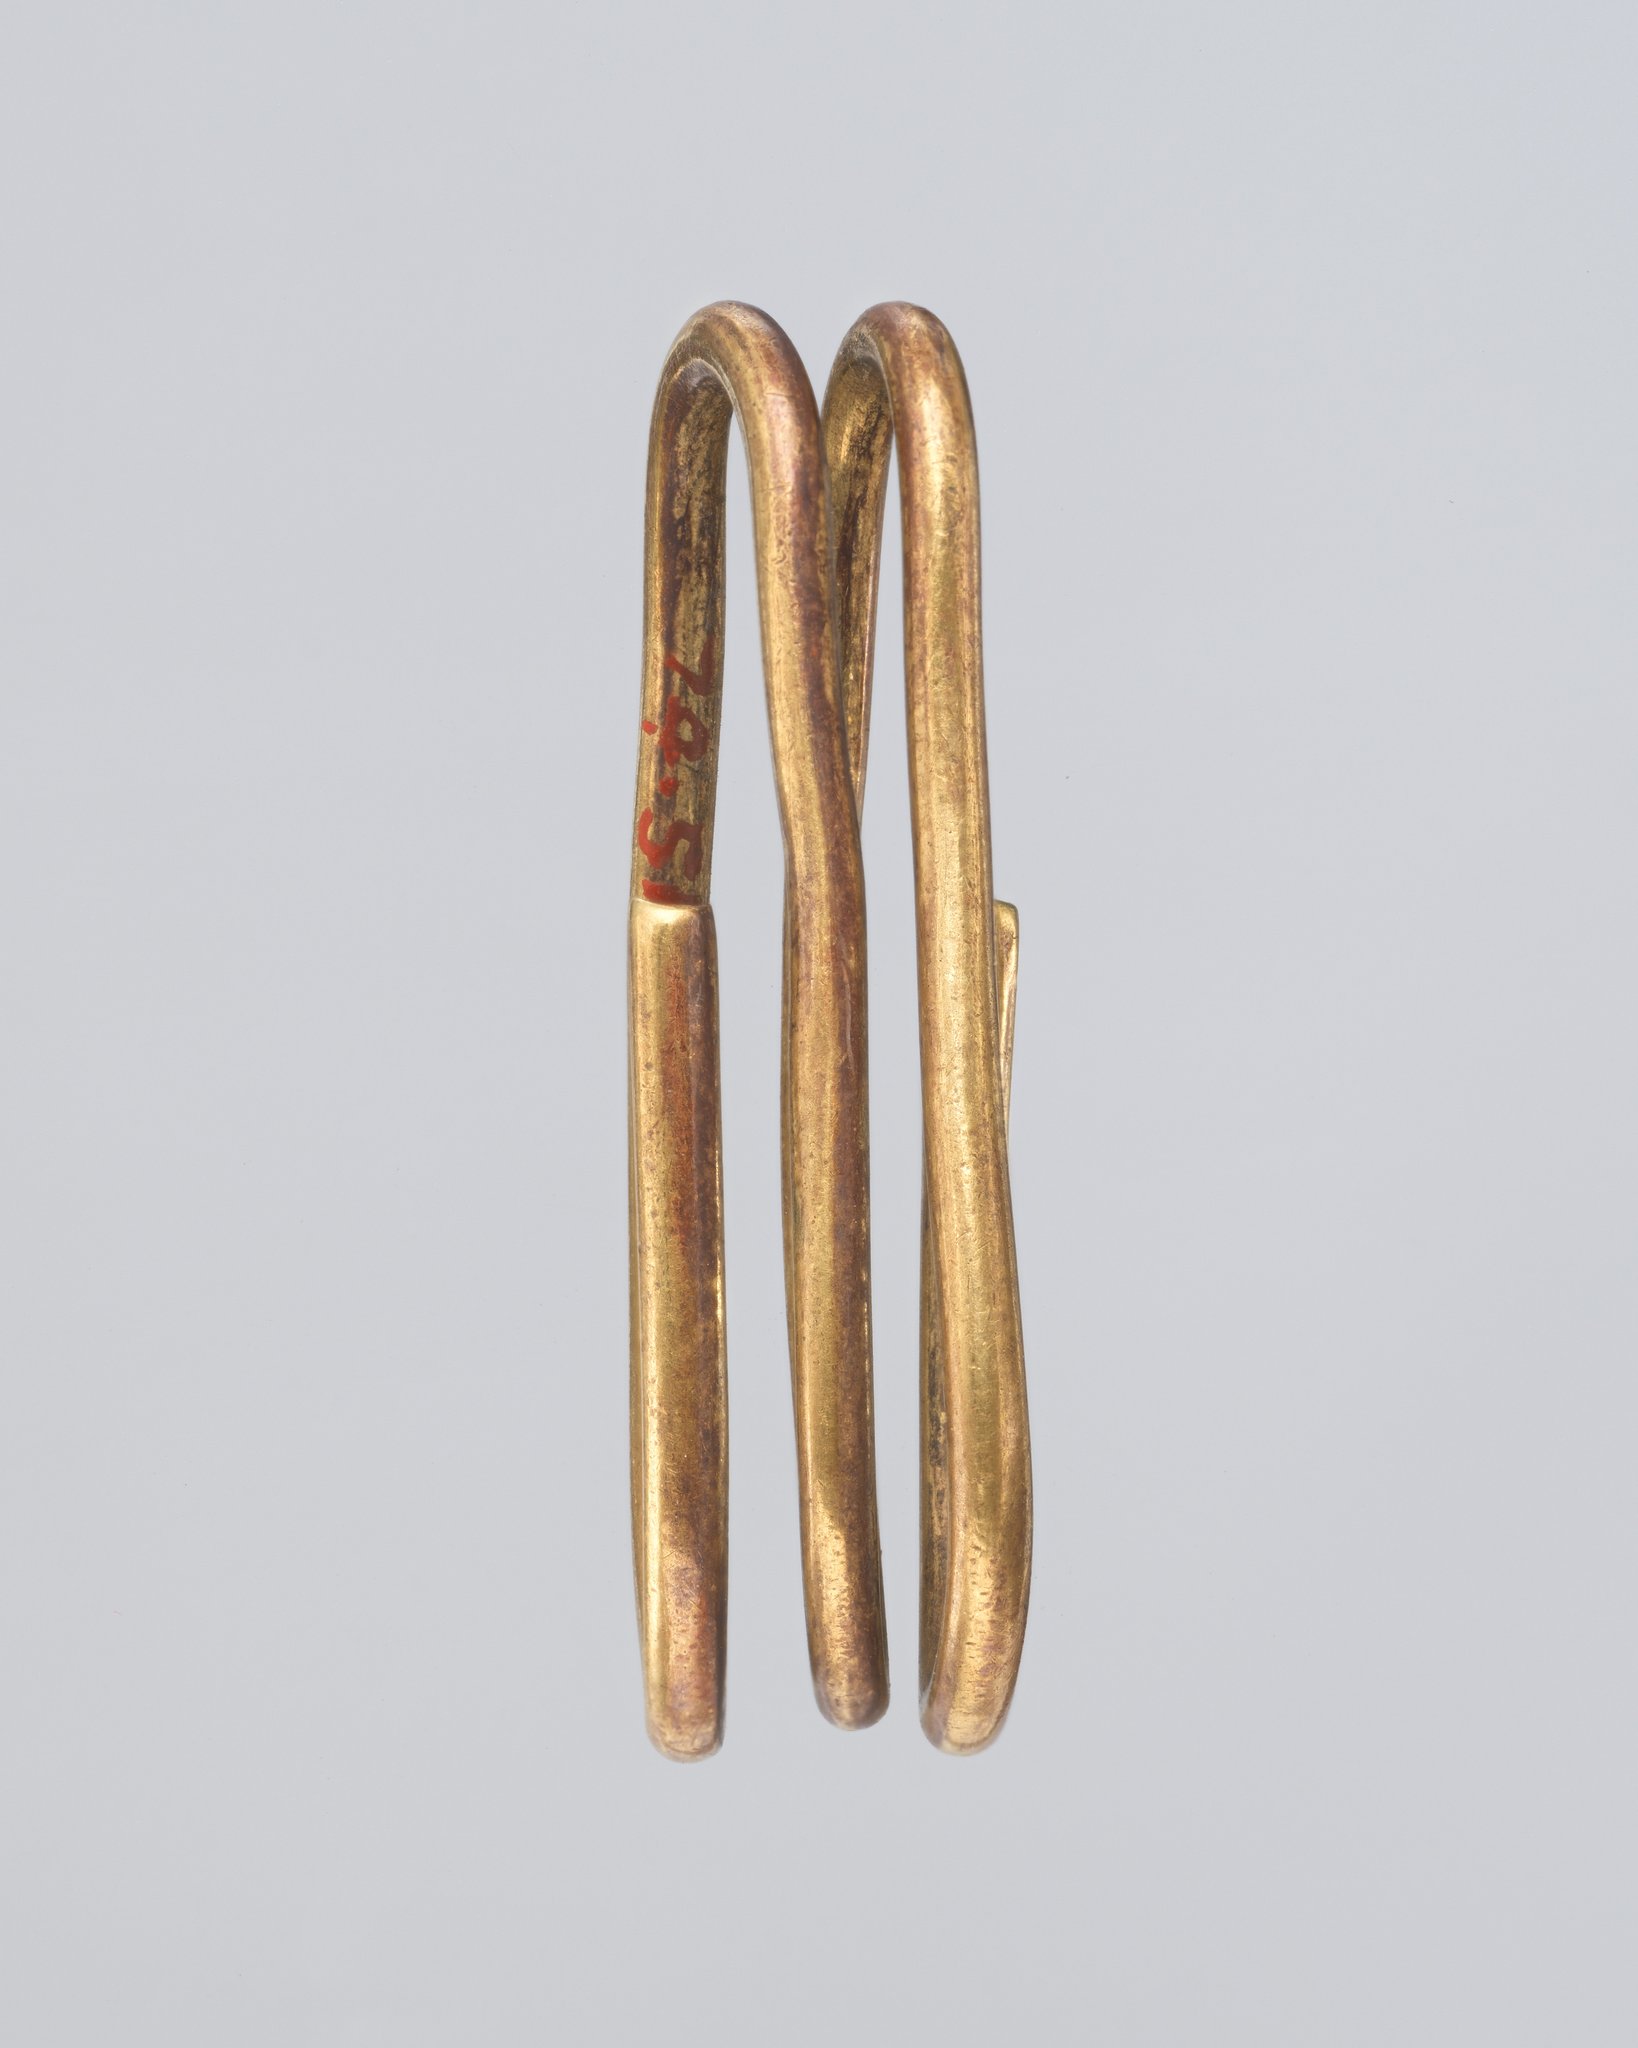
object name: earring or spiral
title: Gold spiral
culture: cypriot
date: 1600-1100 BCE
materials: gold